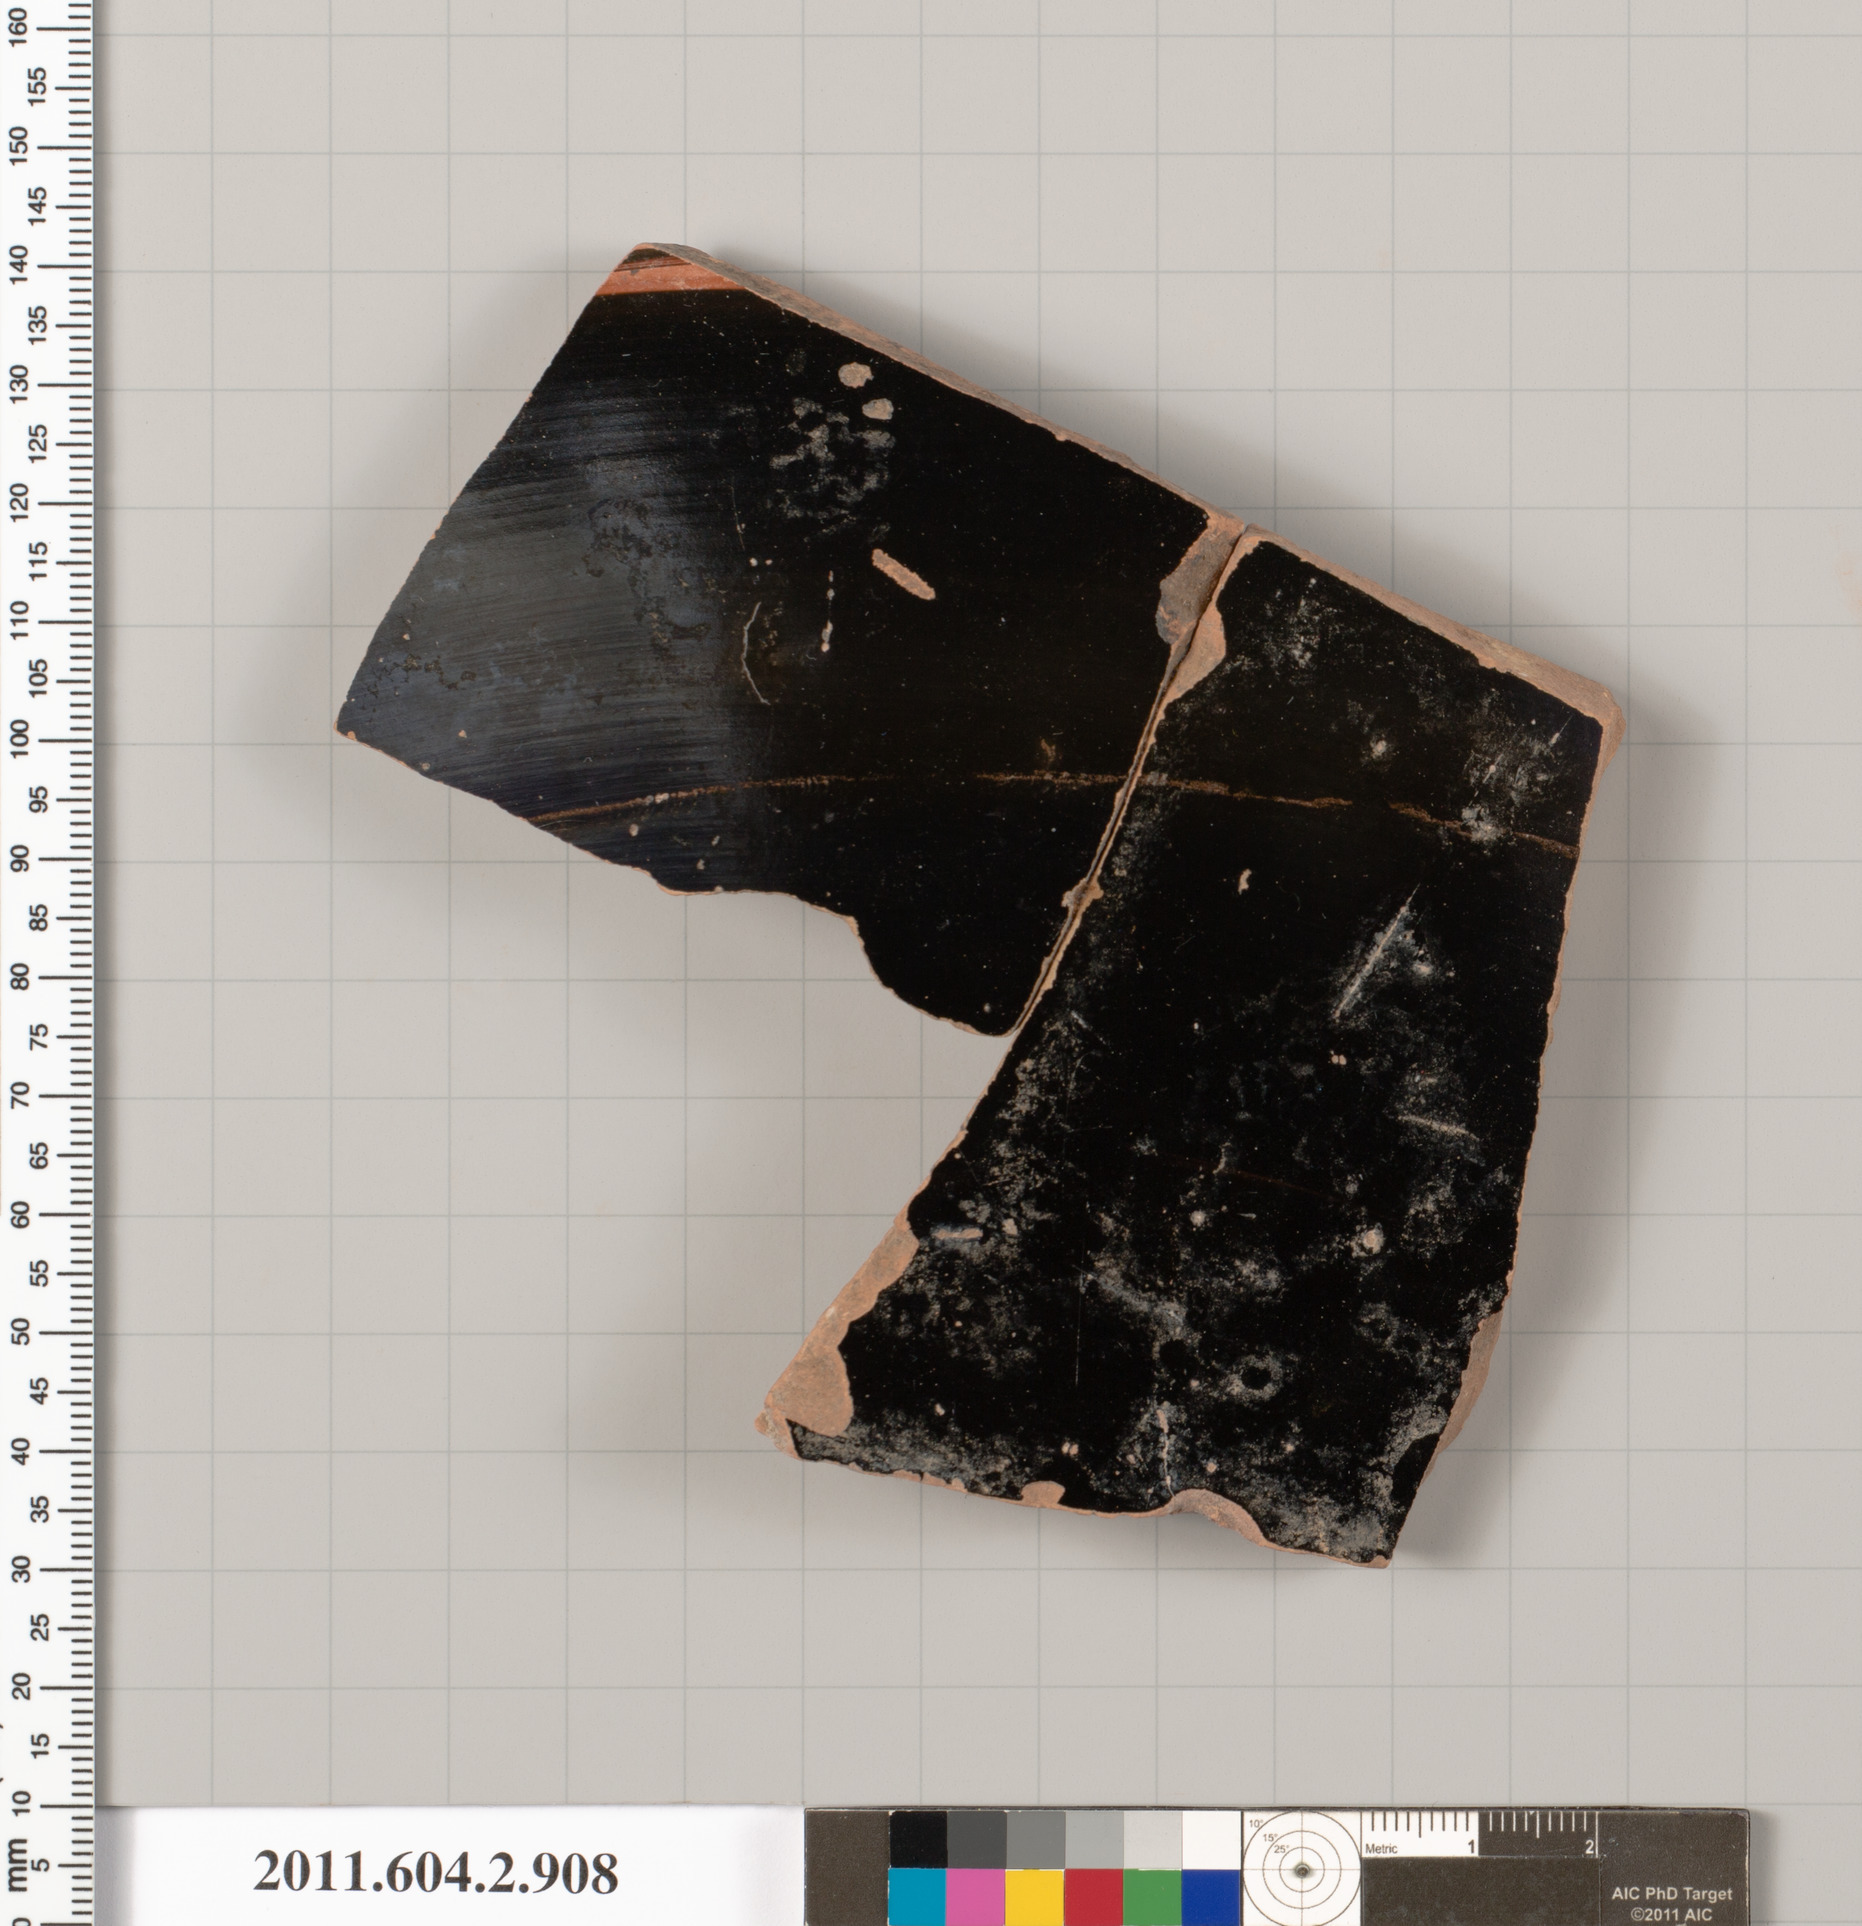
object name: bell krater fragment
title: Terracotta fragment of a bell-krater (bowl for mixing wine and water)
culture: greek, attic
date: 460-440 BCE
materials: terracotta